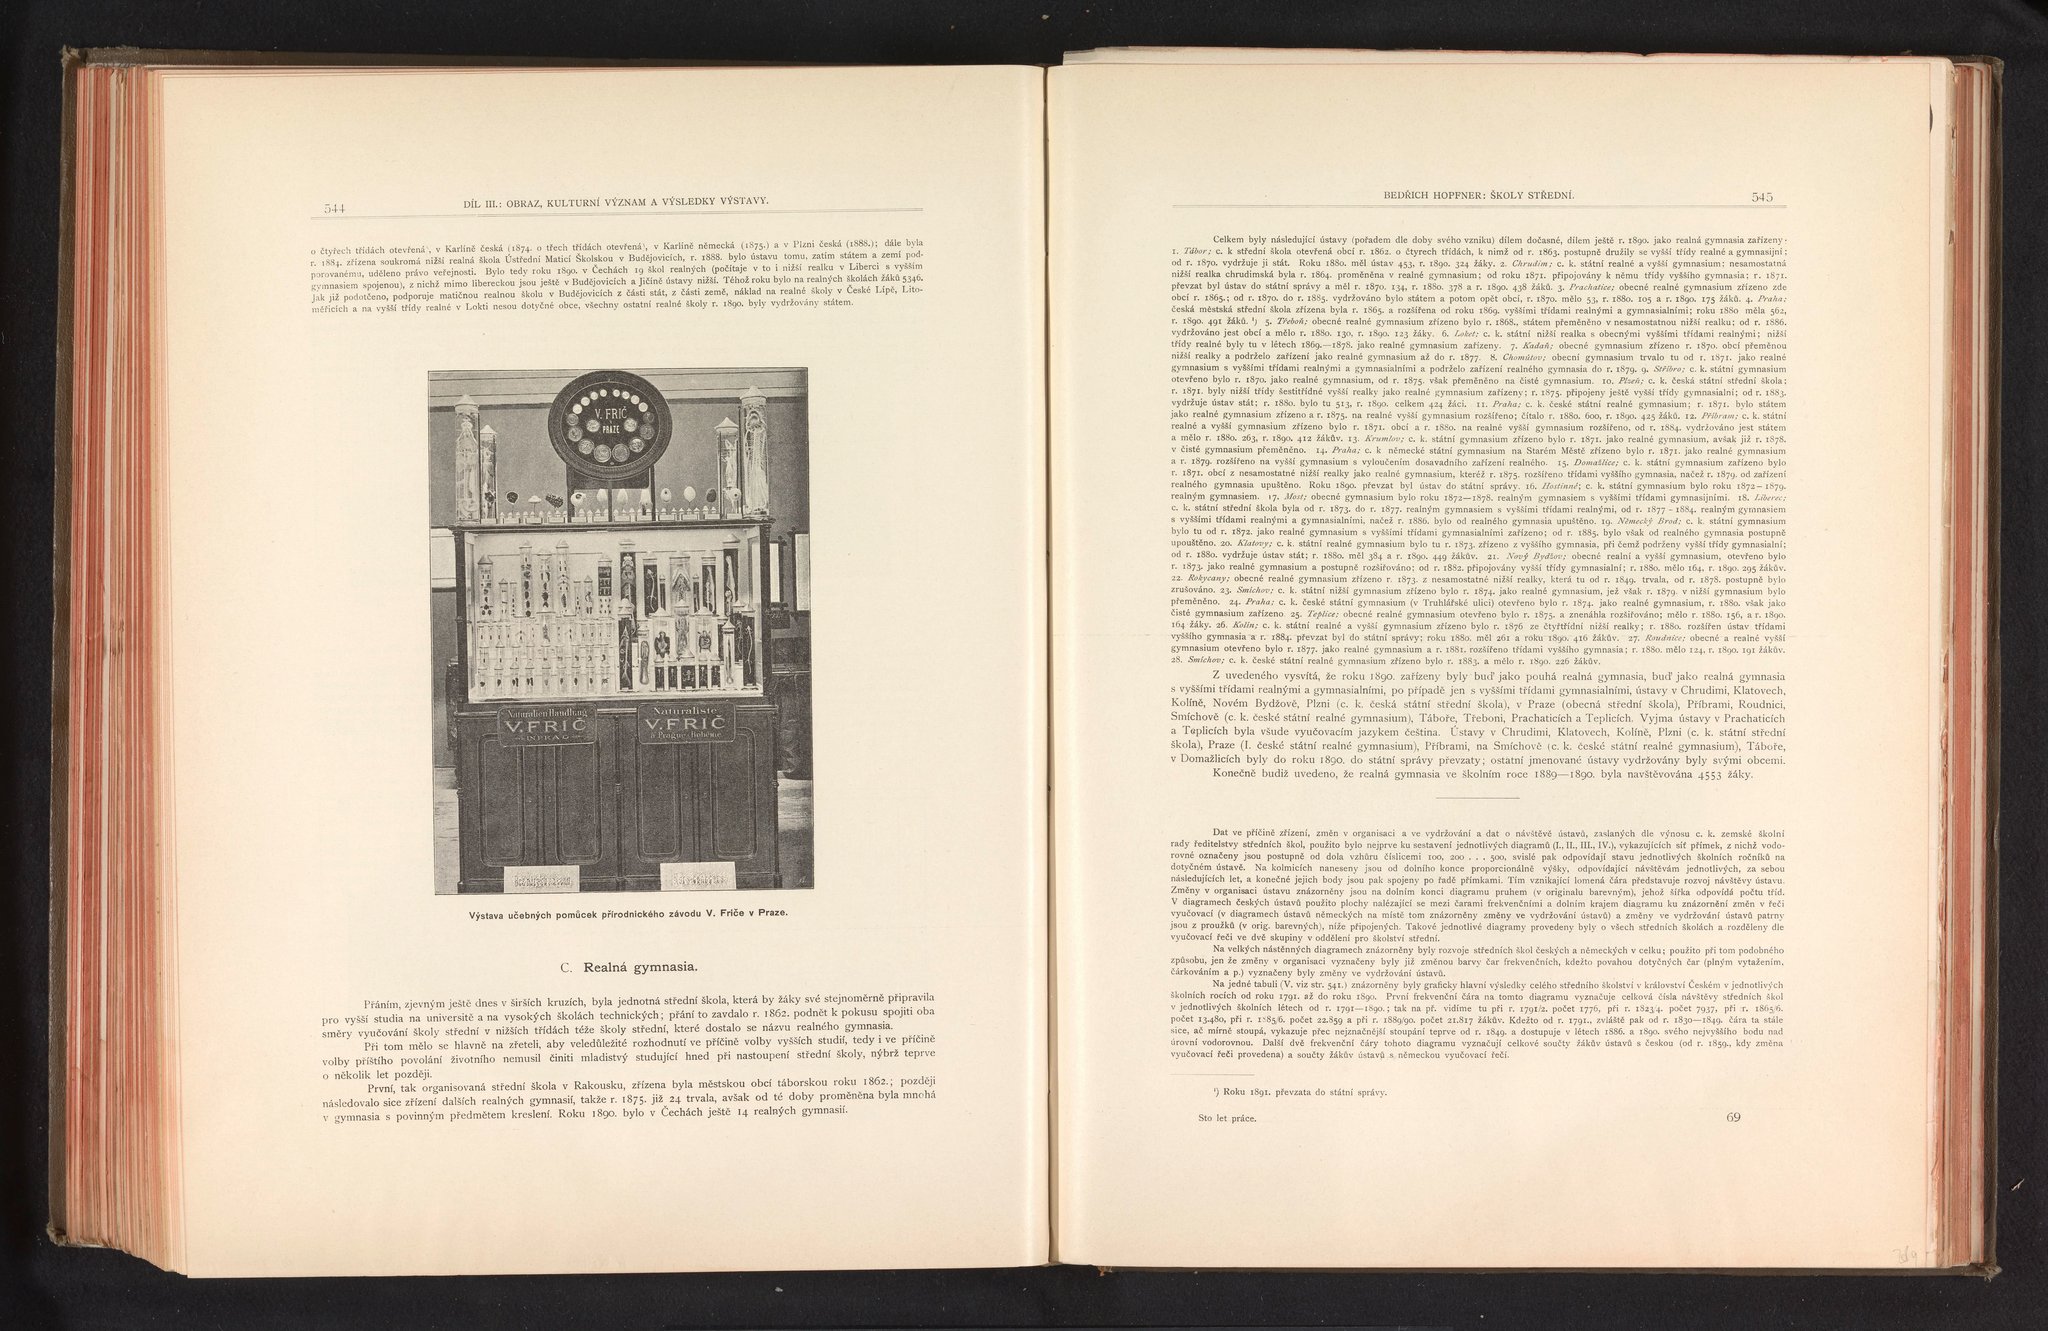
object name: page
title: Výstava ucebných pomucek prirodnického závodu V. Frice v Praze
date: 1891-1895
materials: paper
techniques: autotype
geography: prague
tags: animals (+ skeleton of an animal), collection, exhibition, show